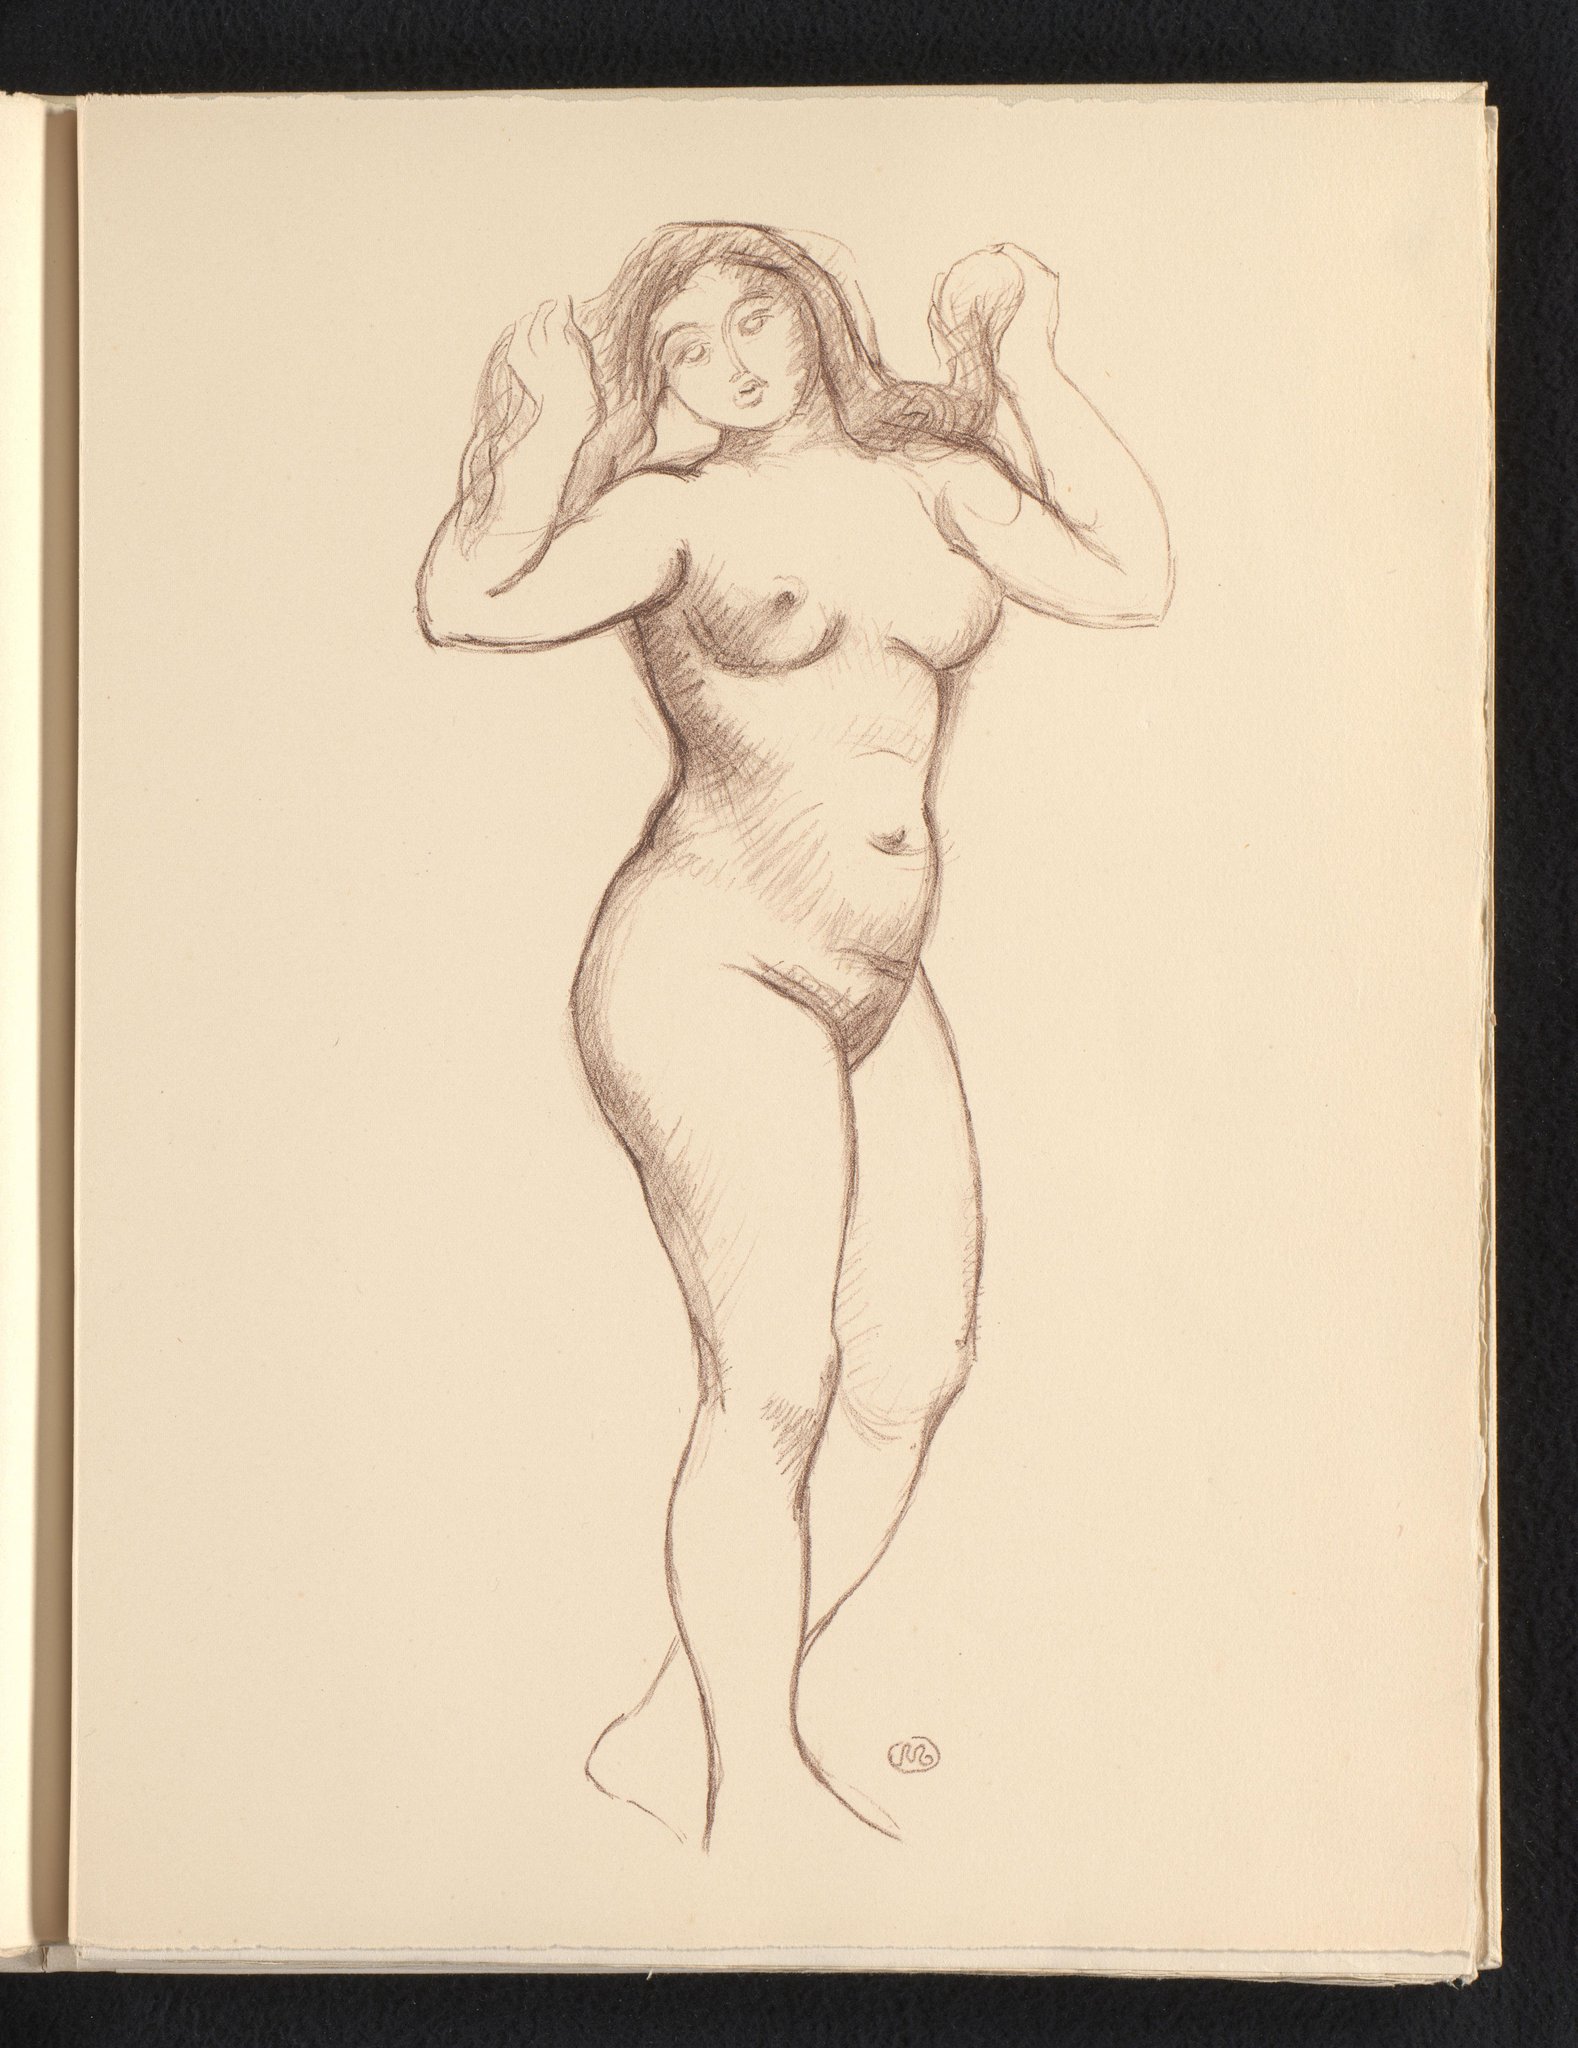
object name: print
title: Staande naakte vrouw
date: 1948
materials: paper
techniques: lithograph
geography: paris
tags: woman (showing herself) undressed, quasi-nude, standing figure - aa - female human figure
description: Prent uit: Lucianus van Samosata. Dialogues des Courtisanes. [Vertaald uit het Grieks door] Charles Astruc. Parijs: s.n., 1948, deel van de suite met een extra afdruk van de prenten in sanguine.